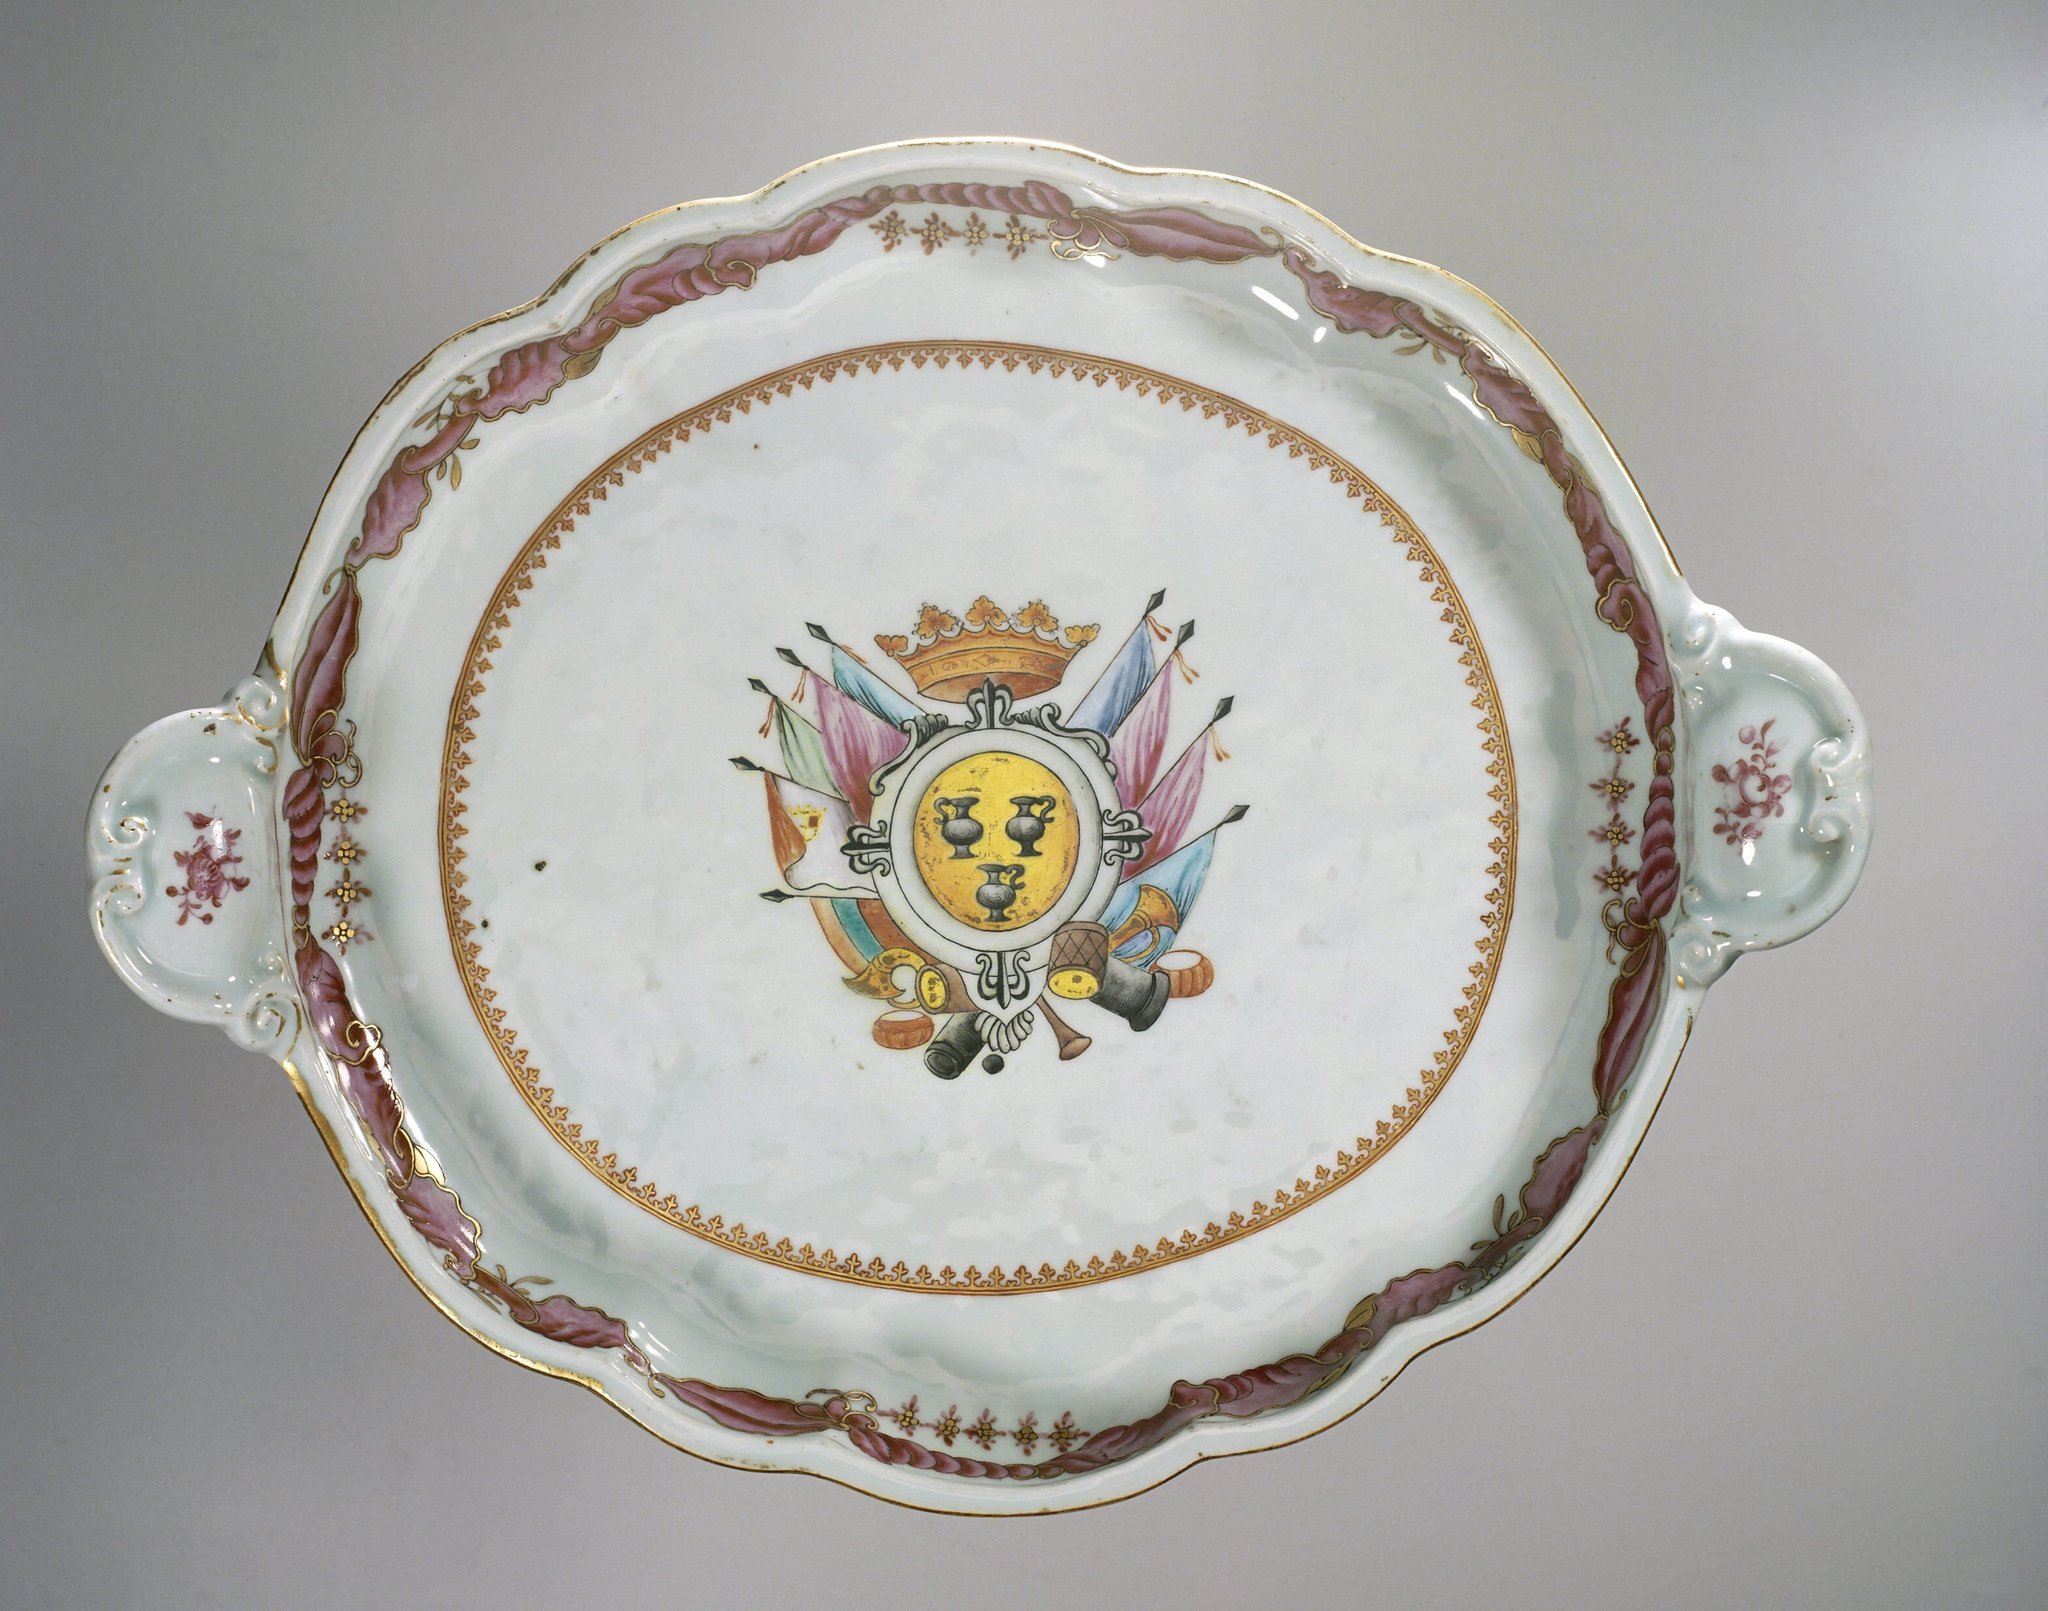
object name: dienblad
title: Oval tray with the arms of the Pignatelli family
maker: Anonymous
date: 1740-1760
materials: glaze, gold, paint, porcelain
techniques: firing, gilding, turning, vitrification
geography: china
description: Ovaal dienblad van porselein met geribde wand en gemodelleerde handvatten, beschilderd op het glazuur in blauw, rood, roze, groen, geel, bruin, zwart en goud. Op het plat het wapen van de familie Pignatelli met drie kannen op een gele grond. Het helmteken is een kroon en het wapen is omgeven door vaandels en militaire objecten. Om het wapen een spearhead-border. Op de wand een Europese decoratieve band met schelpmotief. De handvatten met bloemtakken in Duitse stijl. Wapenporselein met emailkleuren.